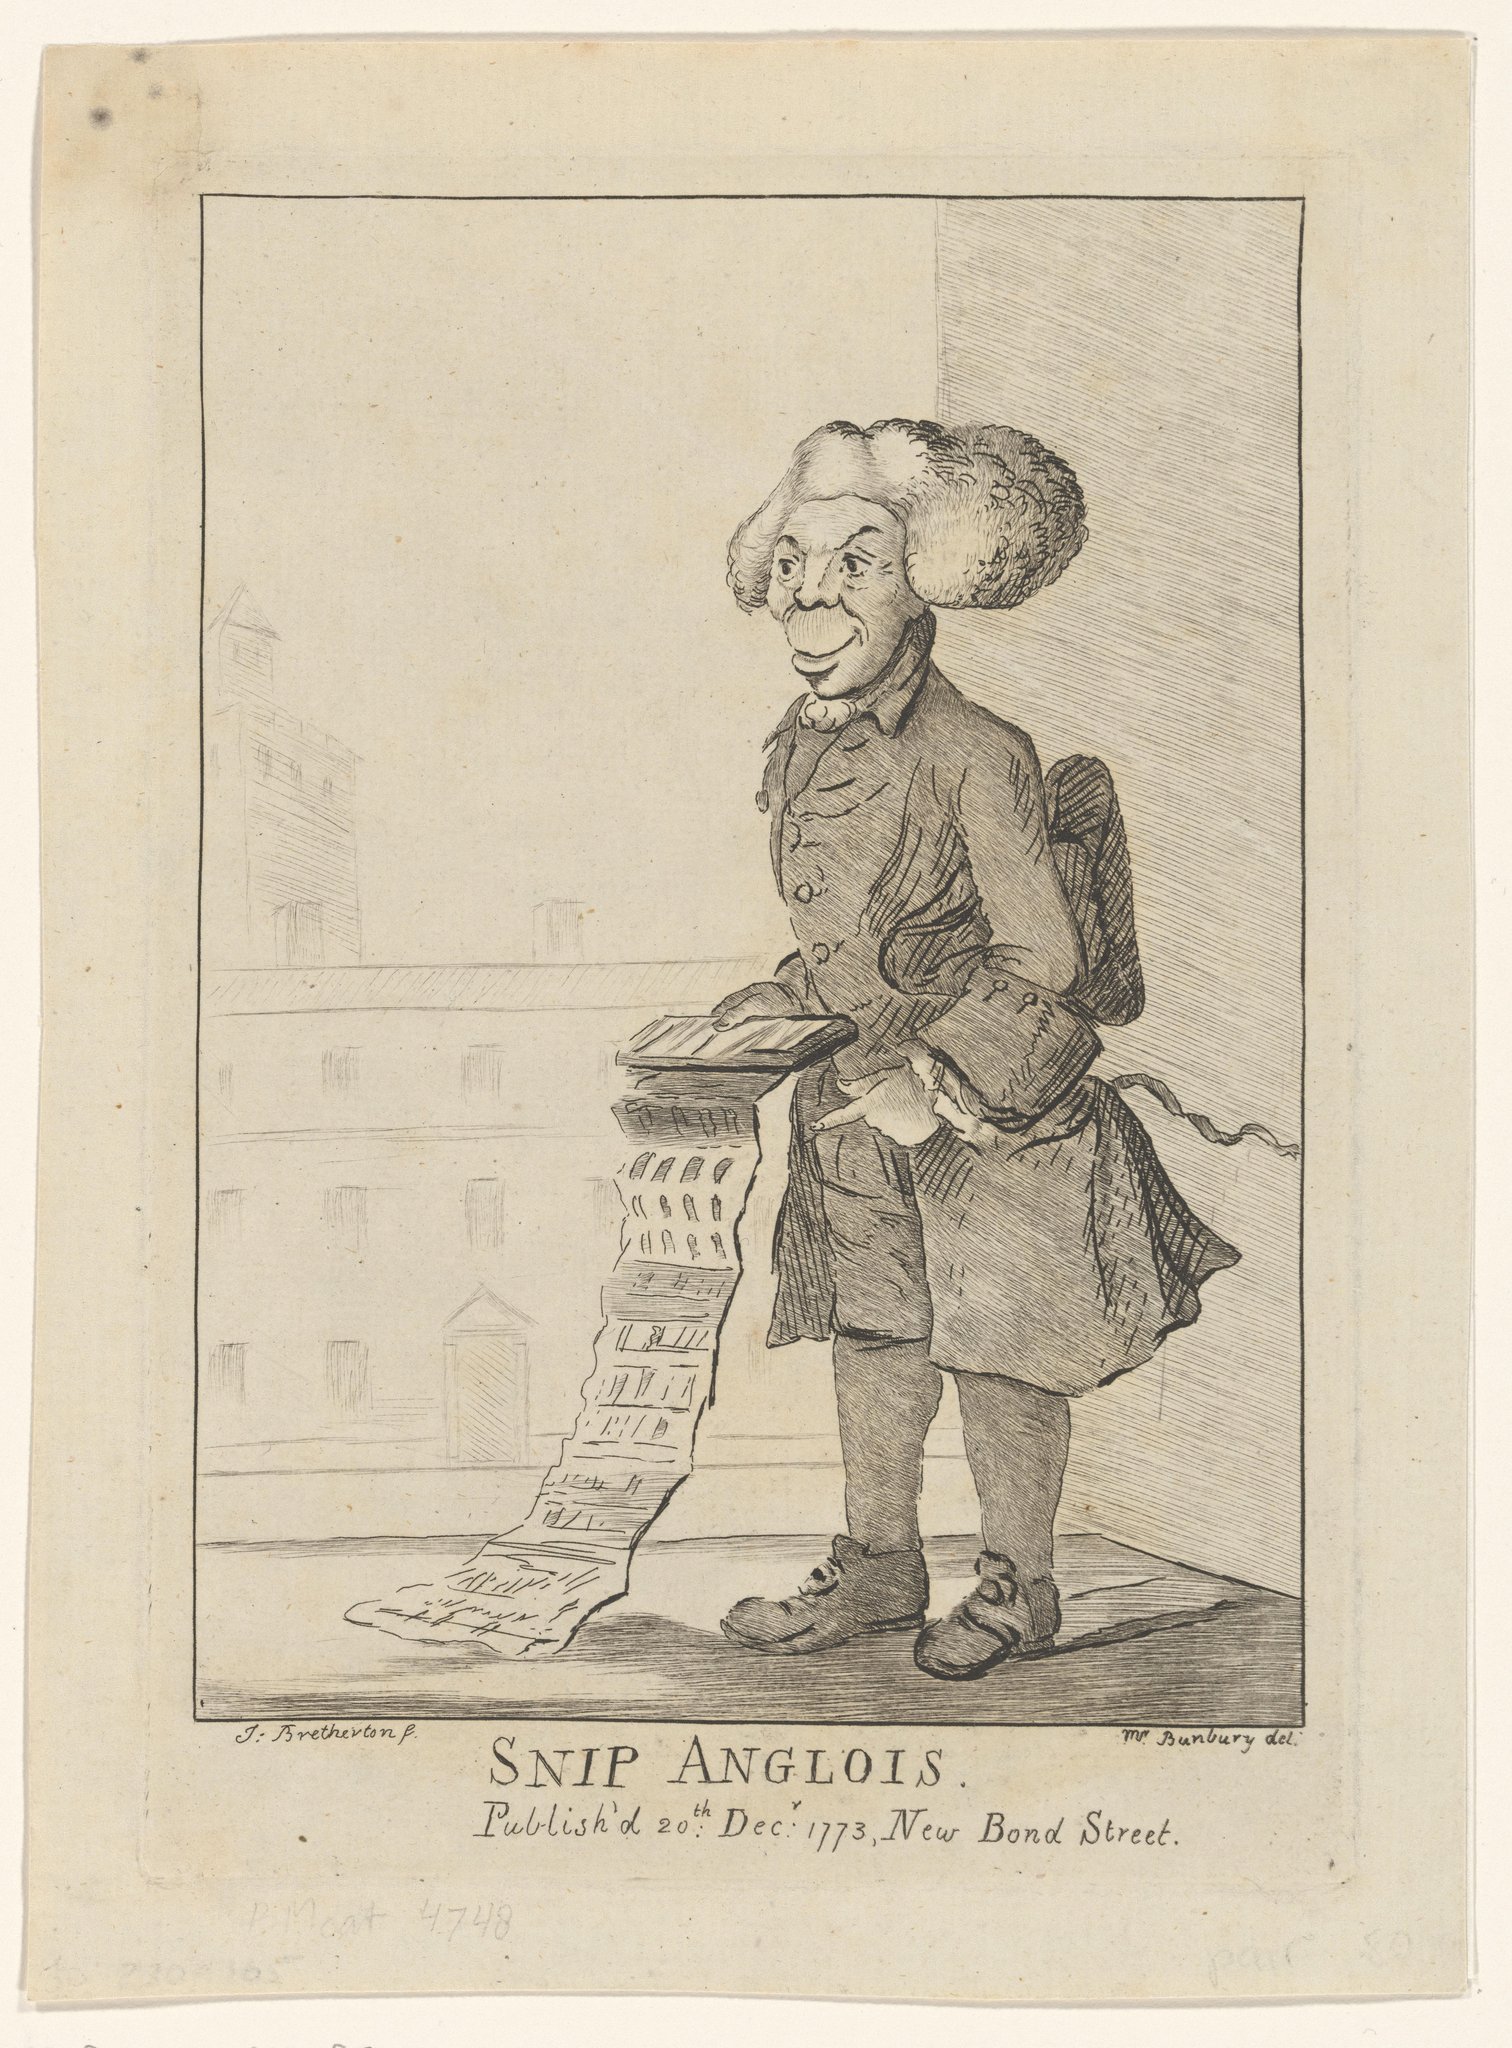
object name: cartoon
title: Snip Anglois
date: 1773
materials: paper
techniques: etching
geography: london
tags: caricatures (human types), europeans: english (+ caricatured), tailor, dressmaker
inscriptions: collector's mark: Lugt 2228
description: Een kleermaker met een harmonicaboek met voorbeeldpatronen. Onder zijn linkerarm klemt hij zijn hoed.